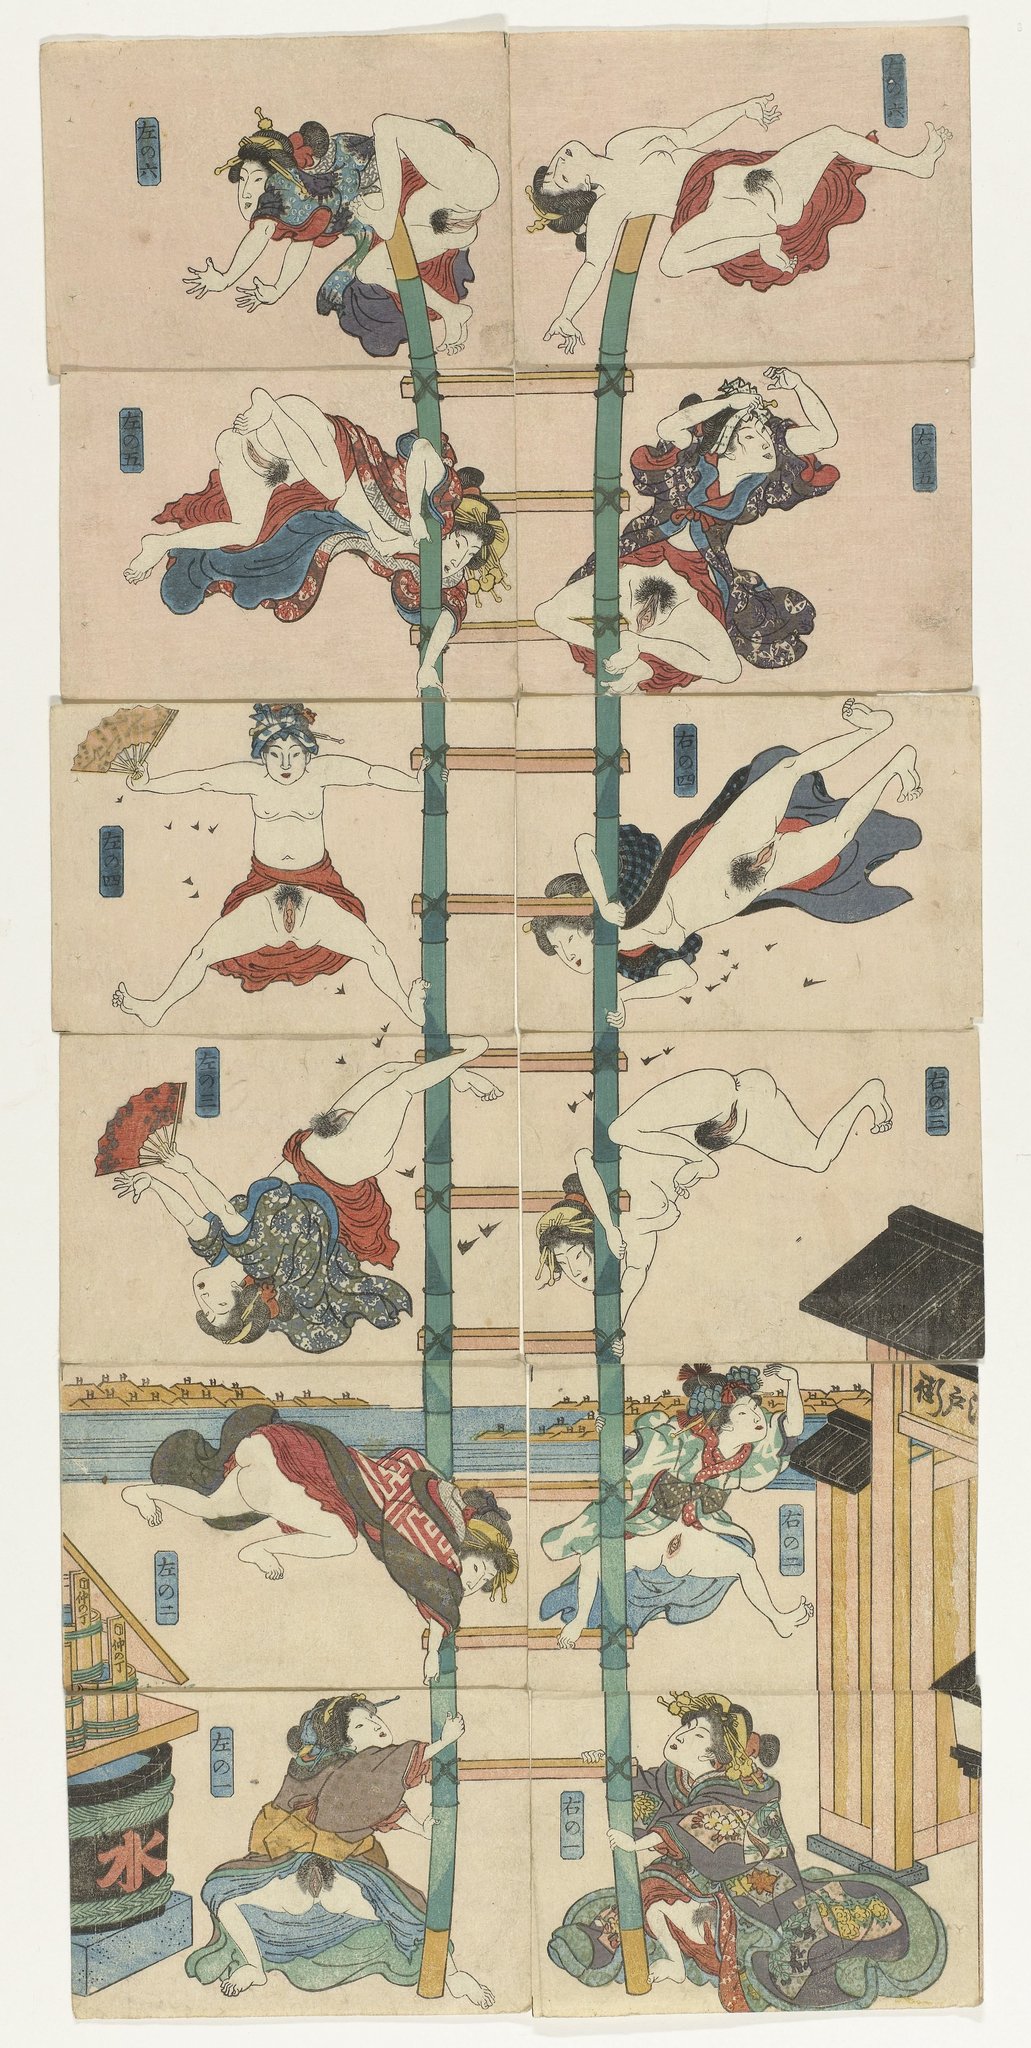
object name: print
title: Serie van twaalf koban Shunga met prostituées in de rol van acrobatische brandweerlieden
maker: utagawa kuniyoshi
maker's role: draughtsman, print maker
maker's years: 1798-1861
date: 1830-1835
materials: paper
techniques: woodcut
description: Serie van twaalf koban prenten met twaalf halfnaakte vrouwen die acrobatische toeren uithalen op een ladder. Per zes boven elkaar geplaatst vormen de twaalf genummerde bladen een parodie op soortgelijke voorstellingen van brandweerlieden die halsbrekende stunts uithalen. De opschriften op de emmers op de één na onderste prent links verwijzen naar de straat Nakanocho in het Yoshiwara district - de prostitutiewijk van Edo. Daaronder is het grote watervat weergegeven dat bij de poort van het Yoshiwara stond; de poort bevindt zich rechts. Mogelijk vormen de twaalf prentjes een kalender met verwijzingen naar de korte en lange maanden.